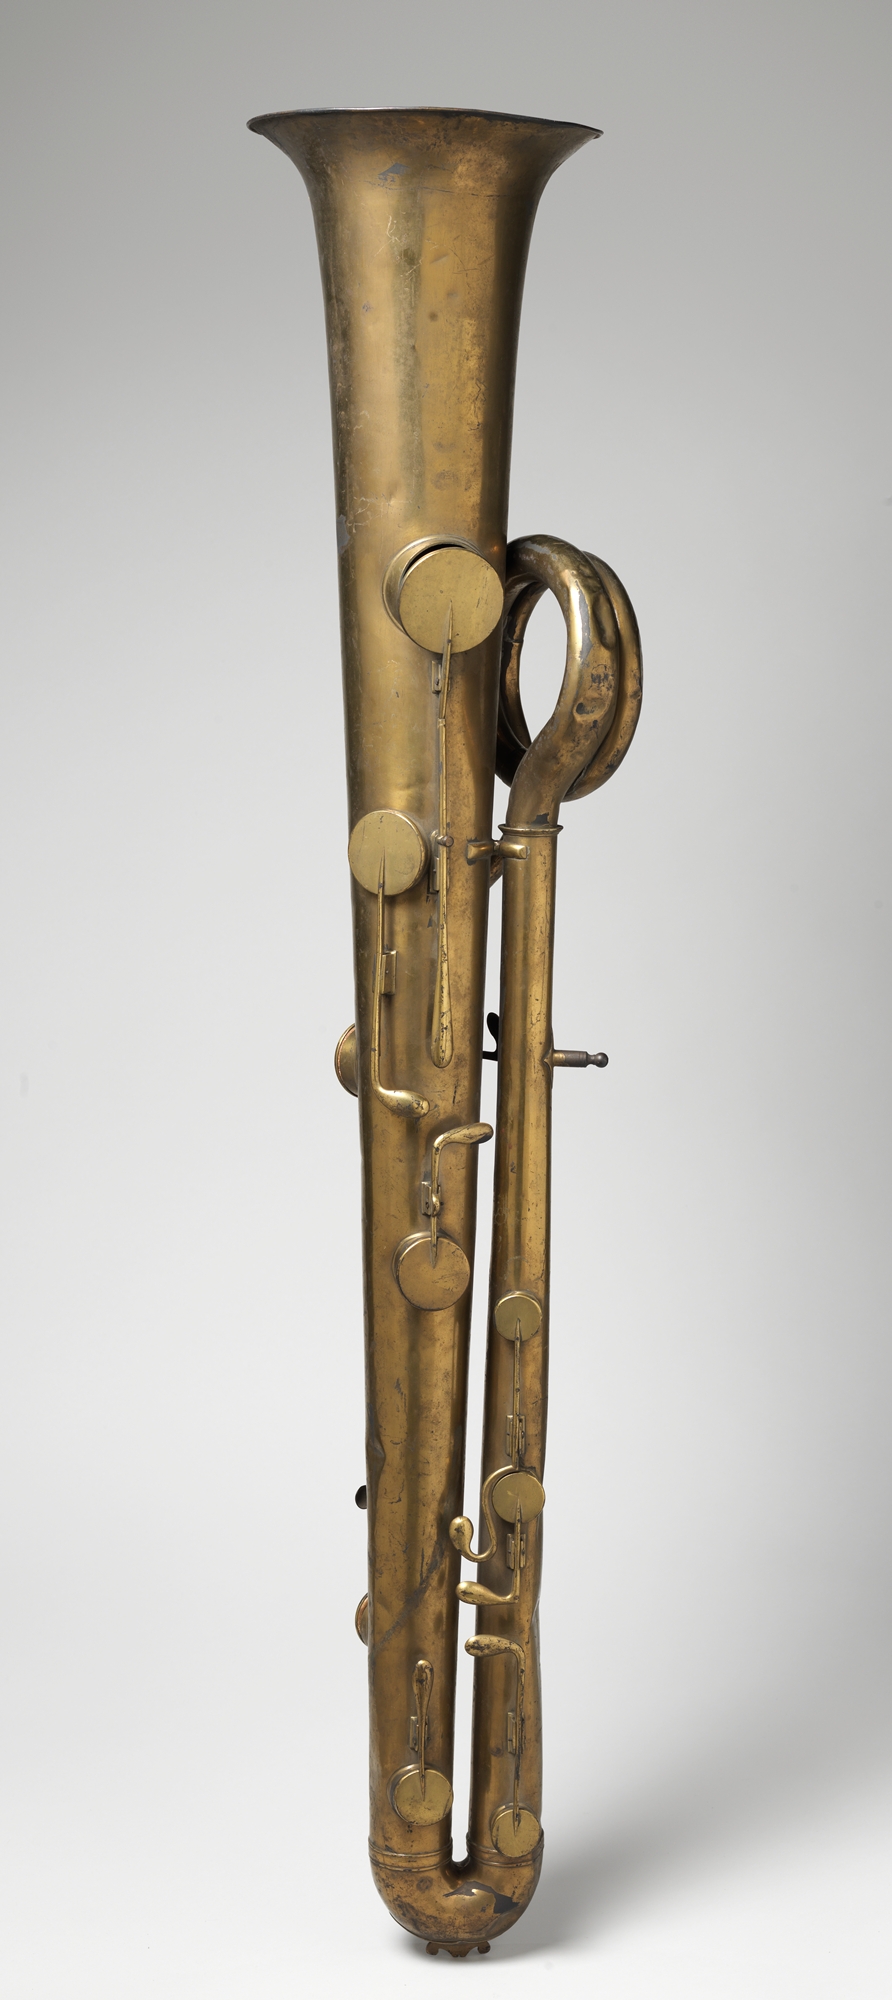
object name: bass ophicleide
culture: french or german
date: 1825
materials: brass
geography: germany